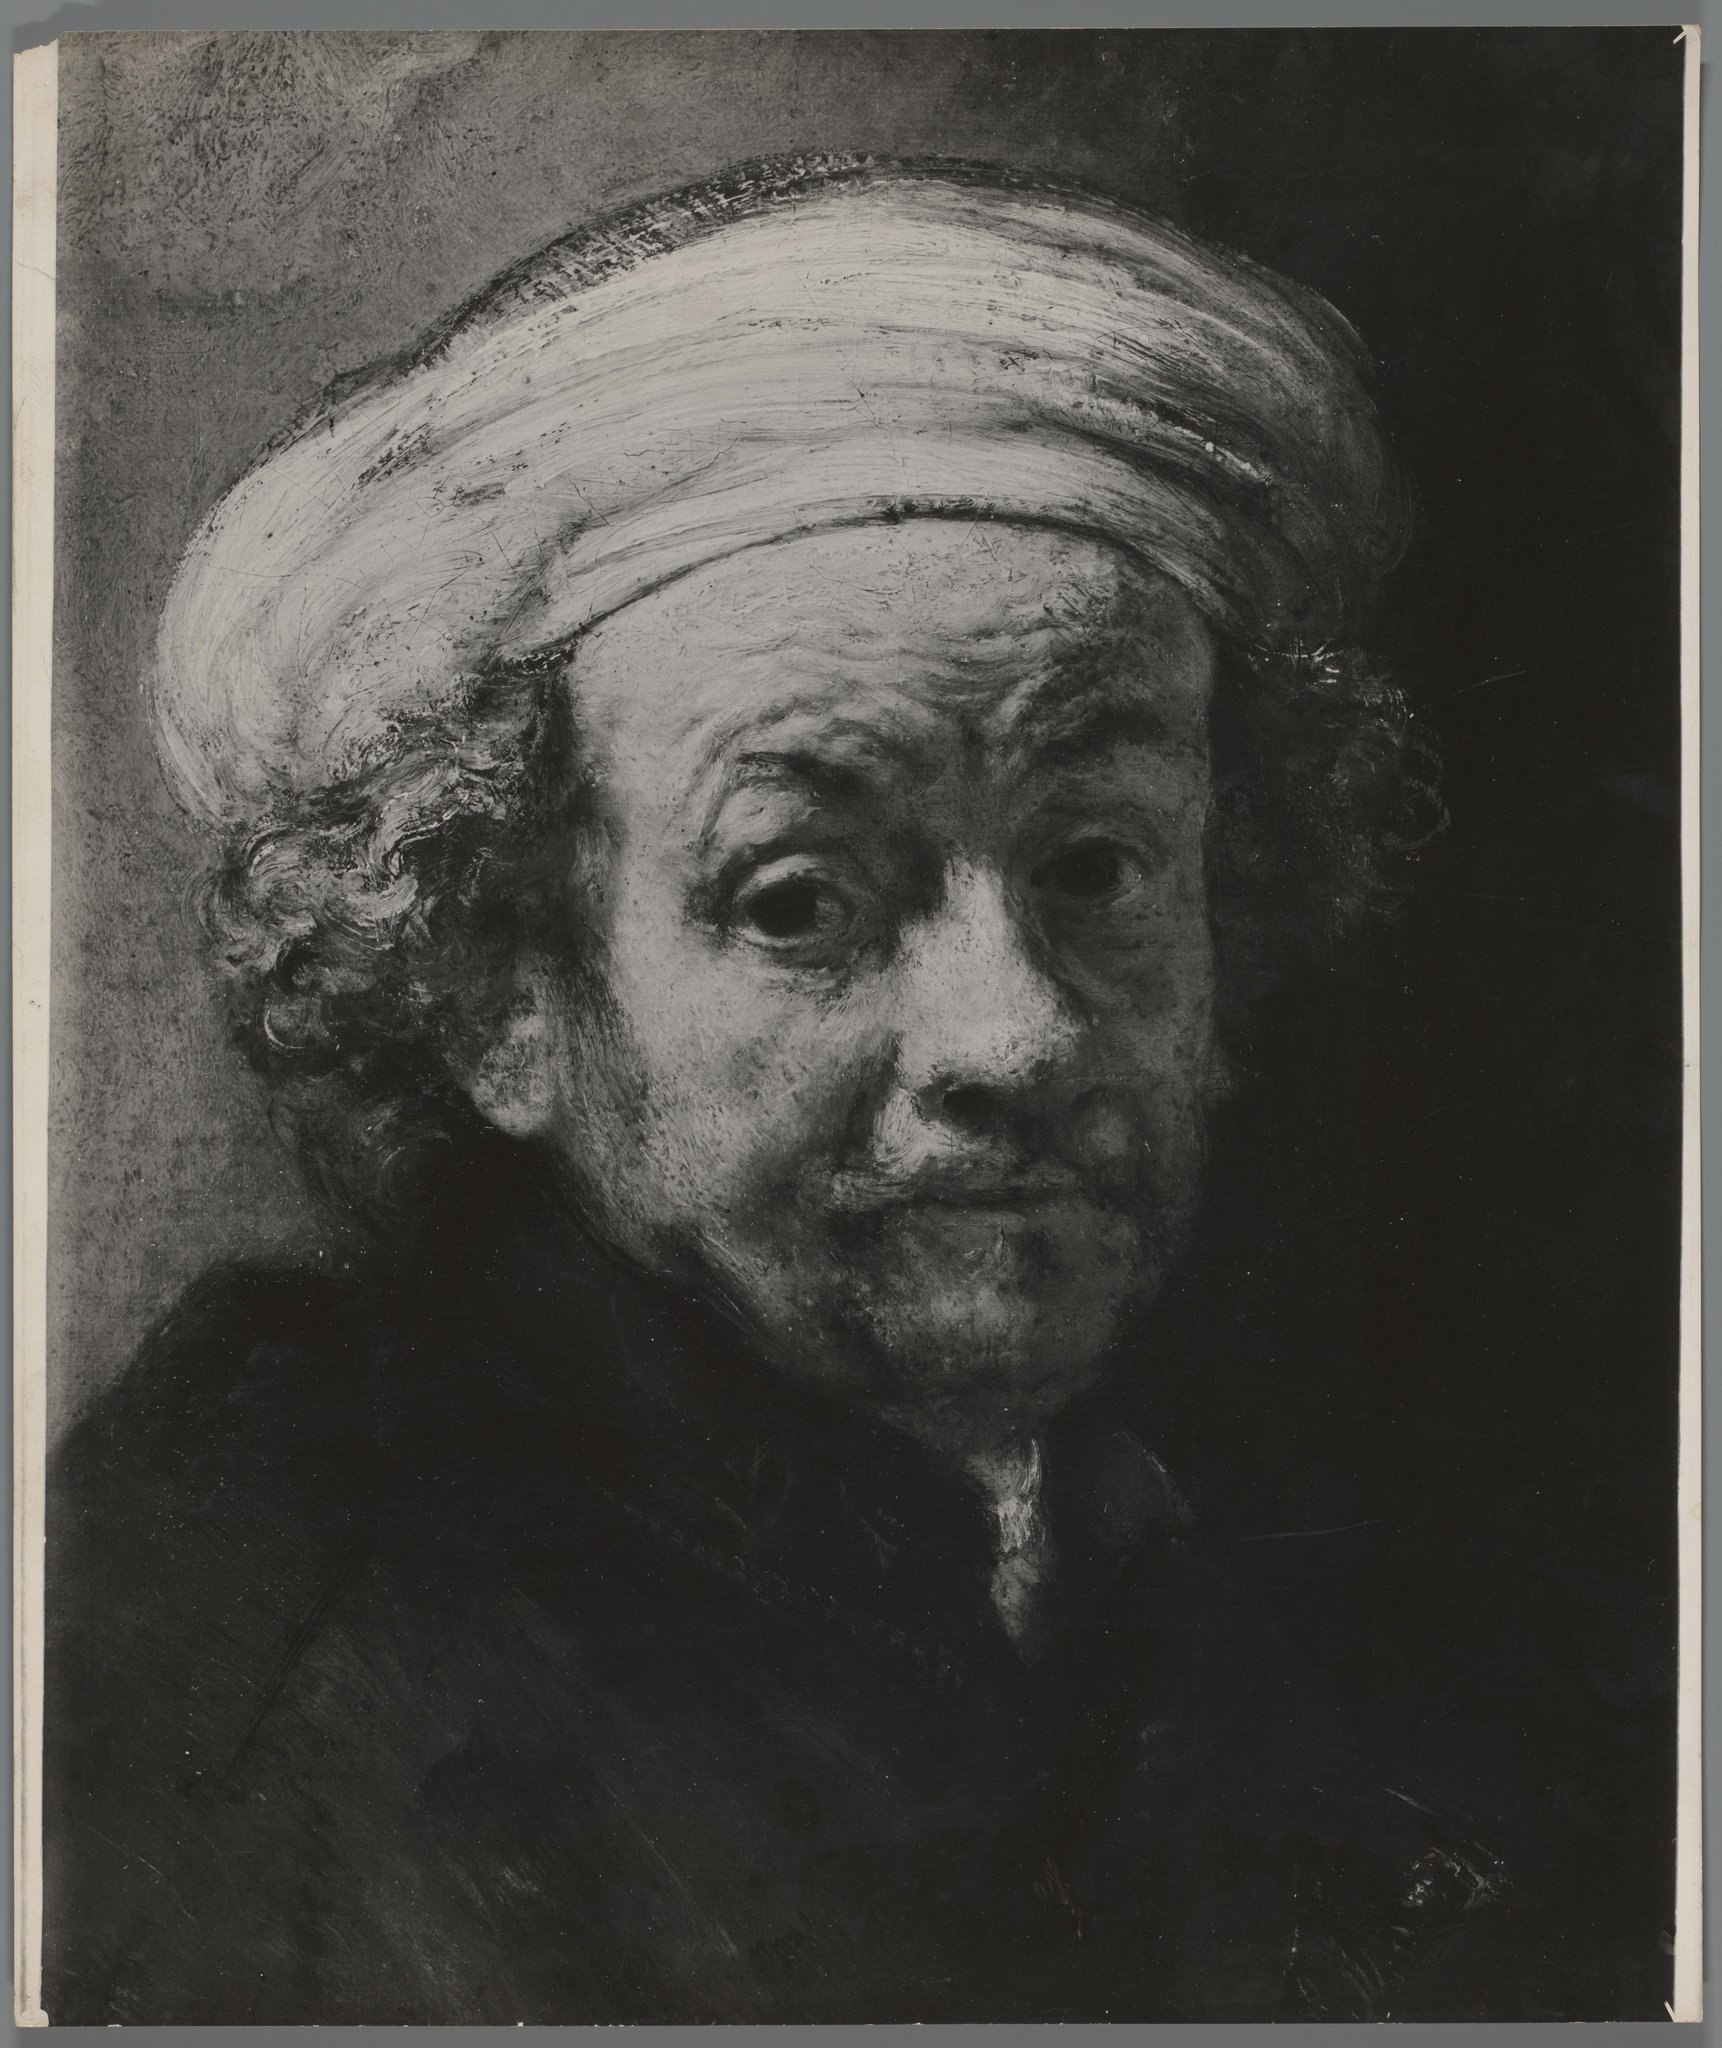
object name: reproduction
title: Fotoreproductie van het schilderij Zelfportret als de apostel Paulus door Rembrandt van Rijn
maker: Anonymous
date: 1890-2023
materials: paper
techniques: gelatin silver print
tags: leiden, amsterdam, painter, print maker, draughtsman, rembrandt van rijn, historical persons, head-gear: turban, (story of) lucius aemilius paul(l)us